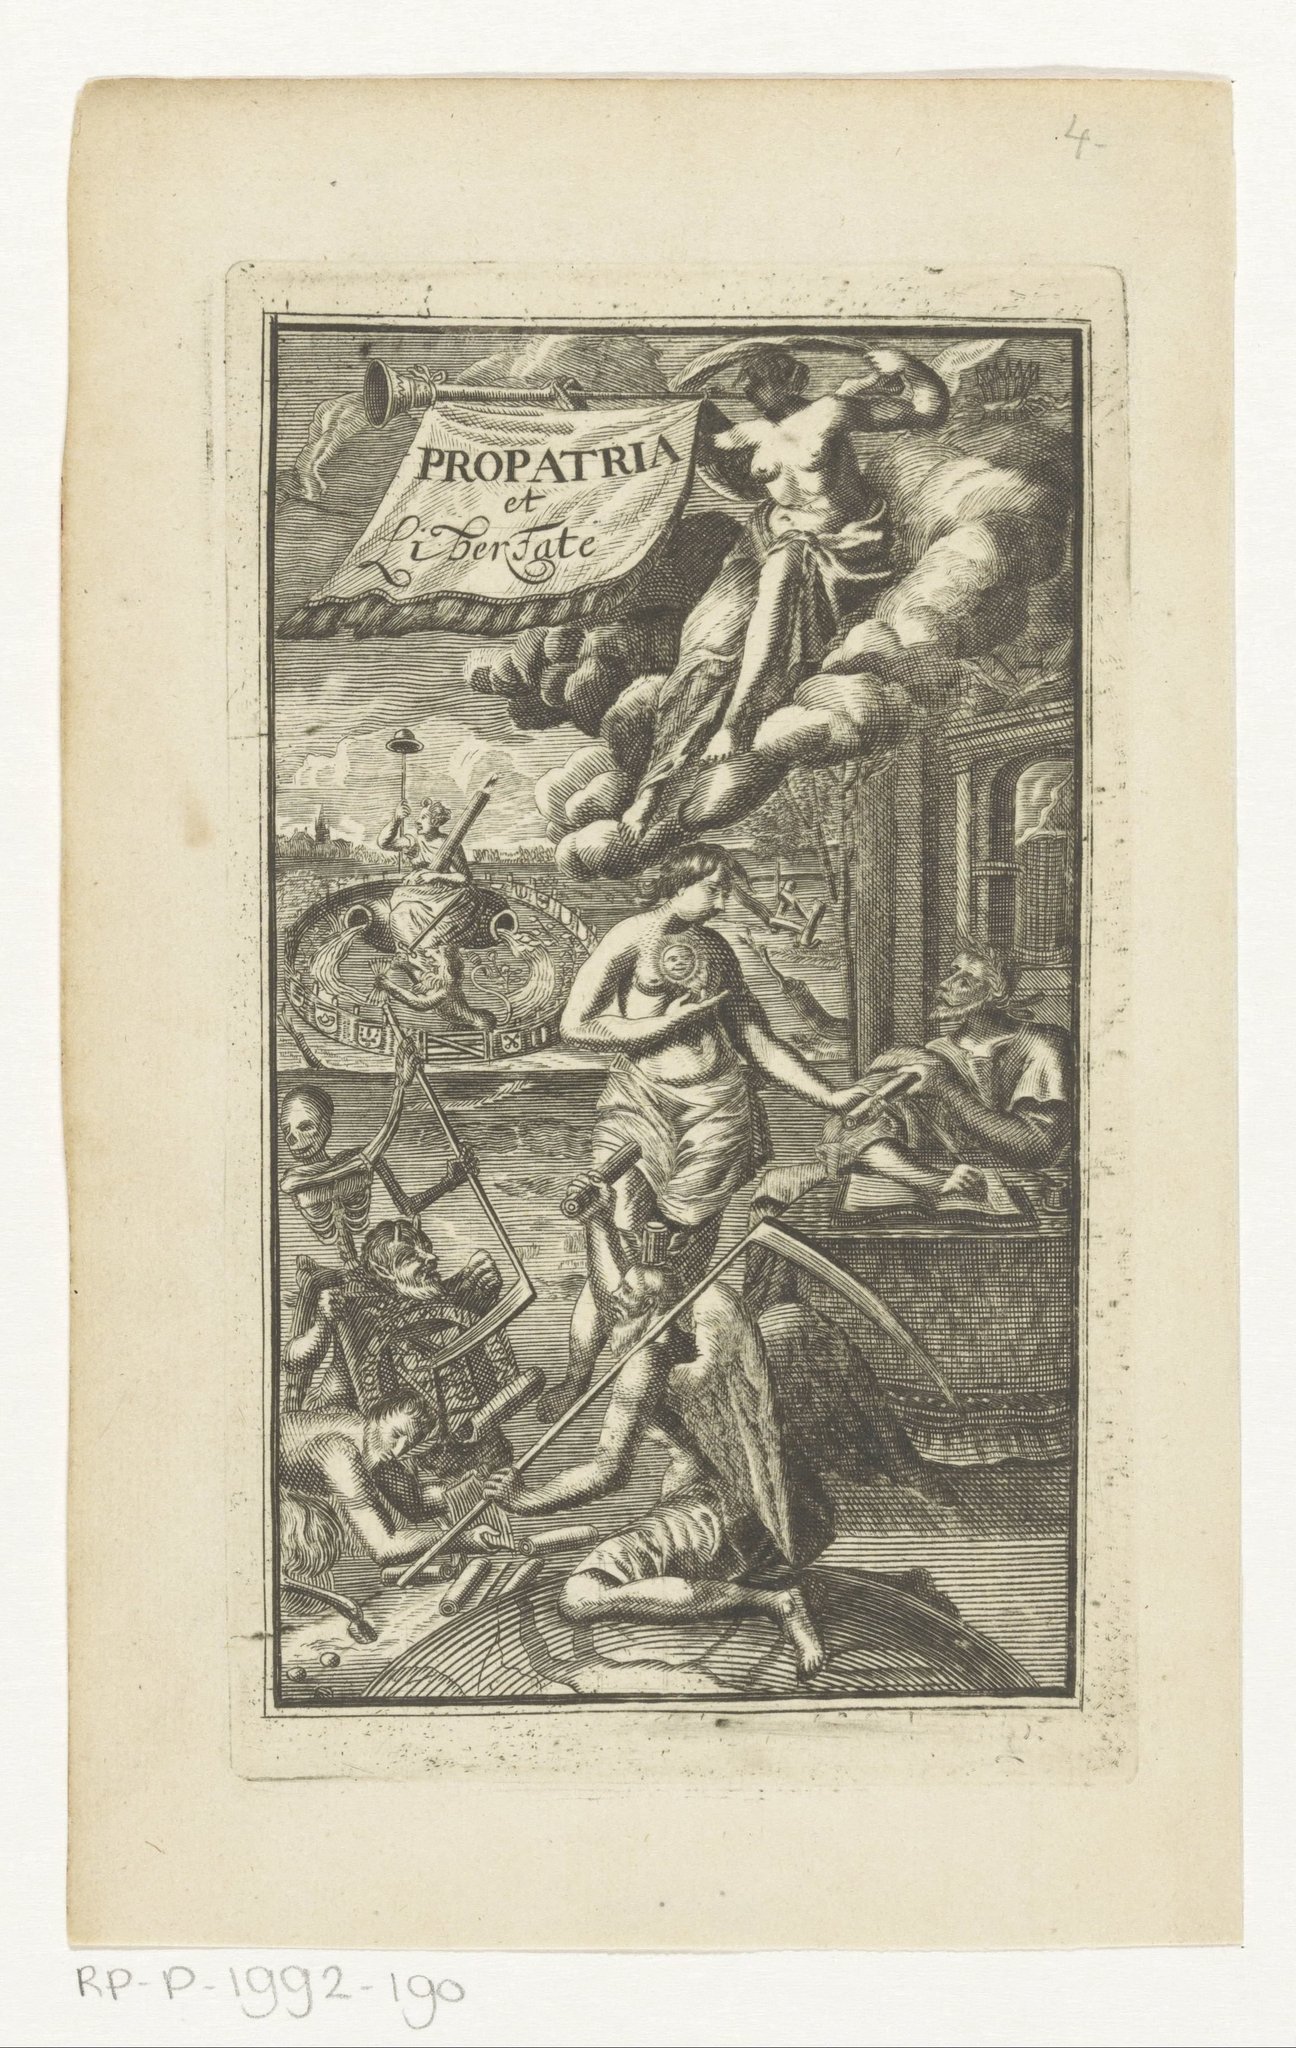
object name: print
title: Allegorische voorstelling met Waarheid of Wijsheid en schrijver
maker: Anonymous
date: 1700-1800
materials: paper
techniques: engraving, etching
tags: wisdom; 'sapienza', 'sapienza humana', 'sapienza vera' (ripa), truth; 'verità' (ripa), writer, poet, author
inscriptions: collector's mark: Lugt 2228, collector's mark: Lugt 2760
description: Een allegorische vrouwenfiguur met een zon op de borst, mogelijk Waarheid of Wijsheid, geeft een schrijver een papierrol. Voor hen zit Vader Tijd met zeis en zandloper op een globe. Links van hem zitten een voorovergebogen sater met papier en een figuur met een opengerold papier waarin een skelet zijn zeis steekt. In de achtergrond de Nederlandse maagd met de Nederlandse leeuw in de Nederlandse tuin. Aan de bovenzijde zit een engel met bazuin, mogelijk Fama, op wolken. Aan de bazuin hangt een banier met titel.